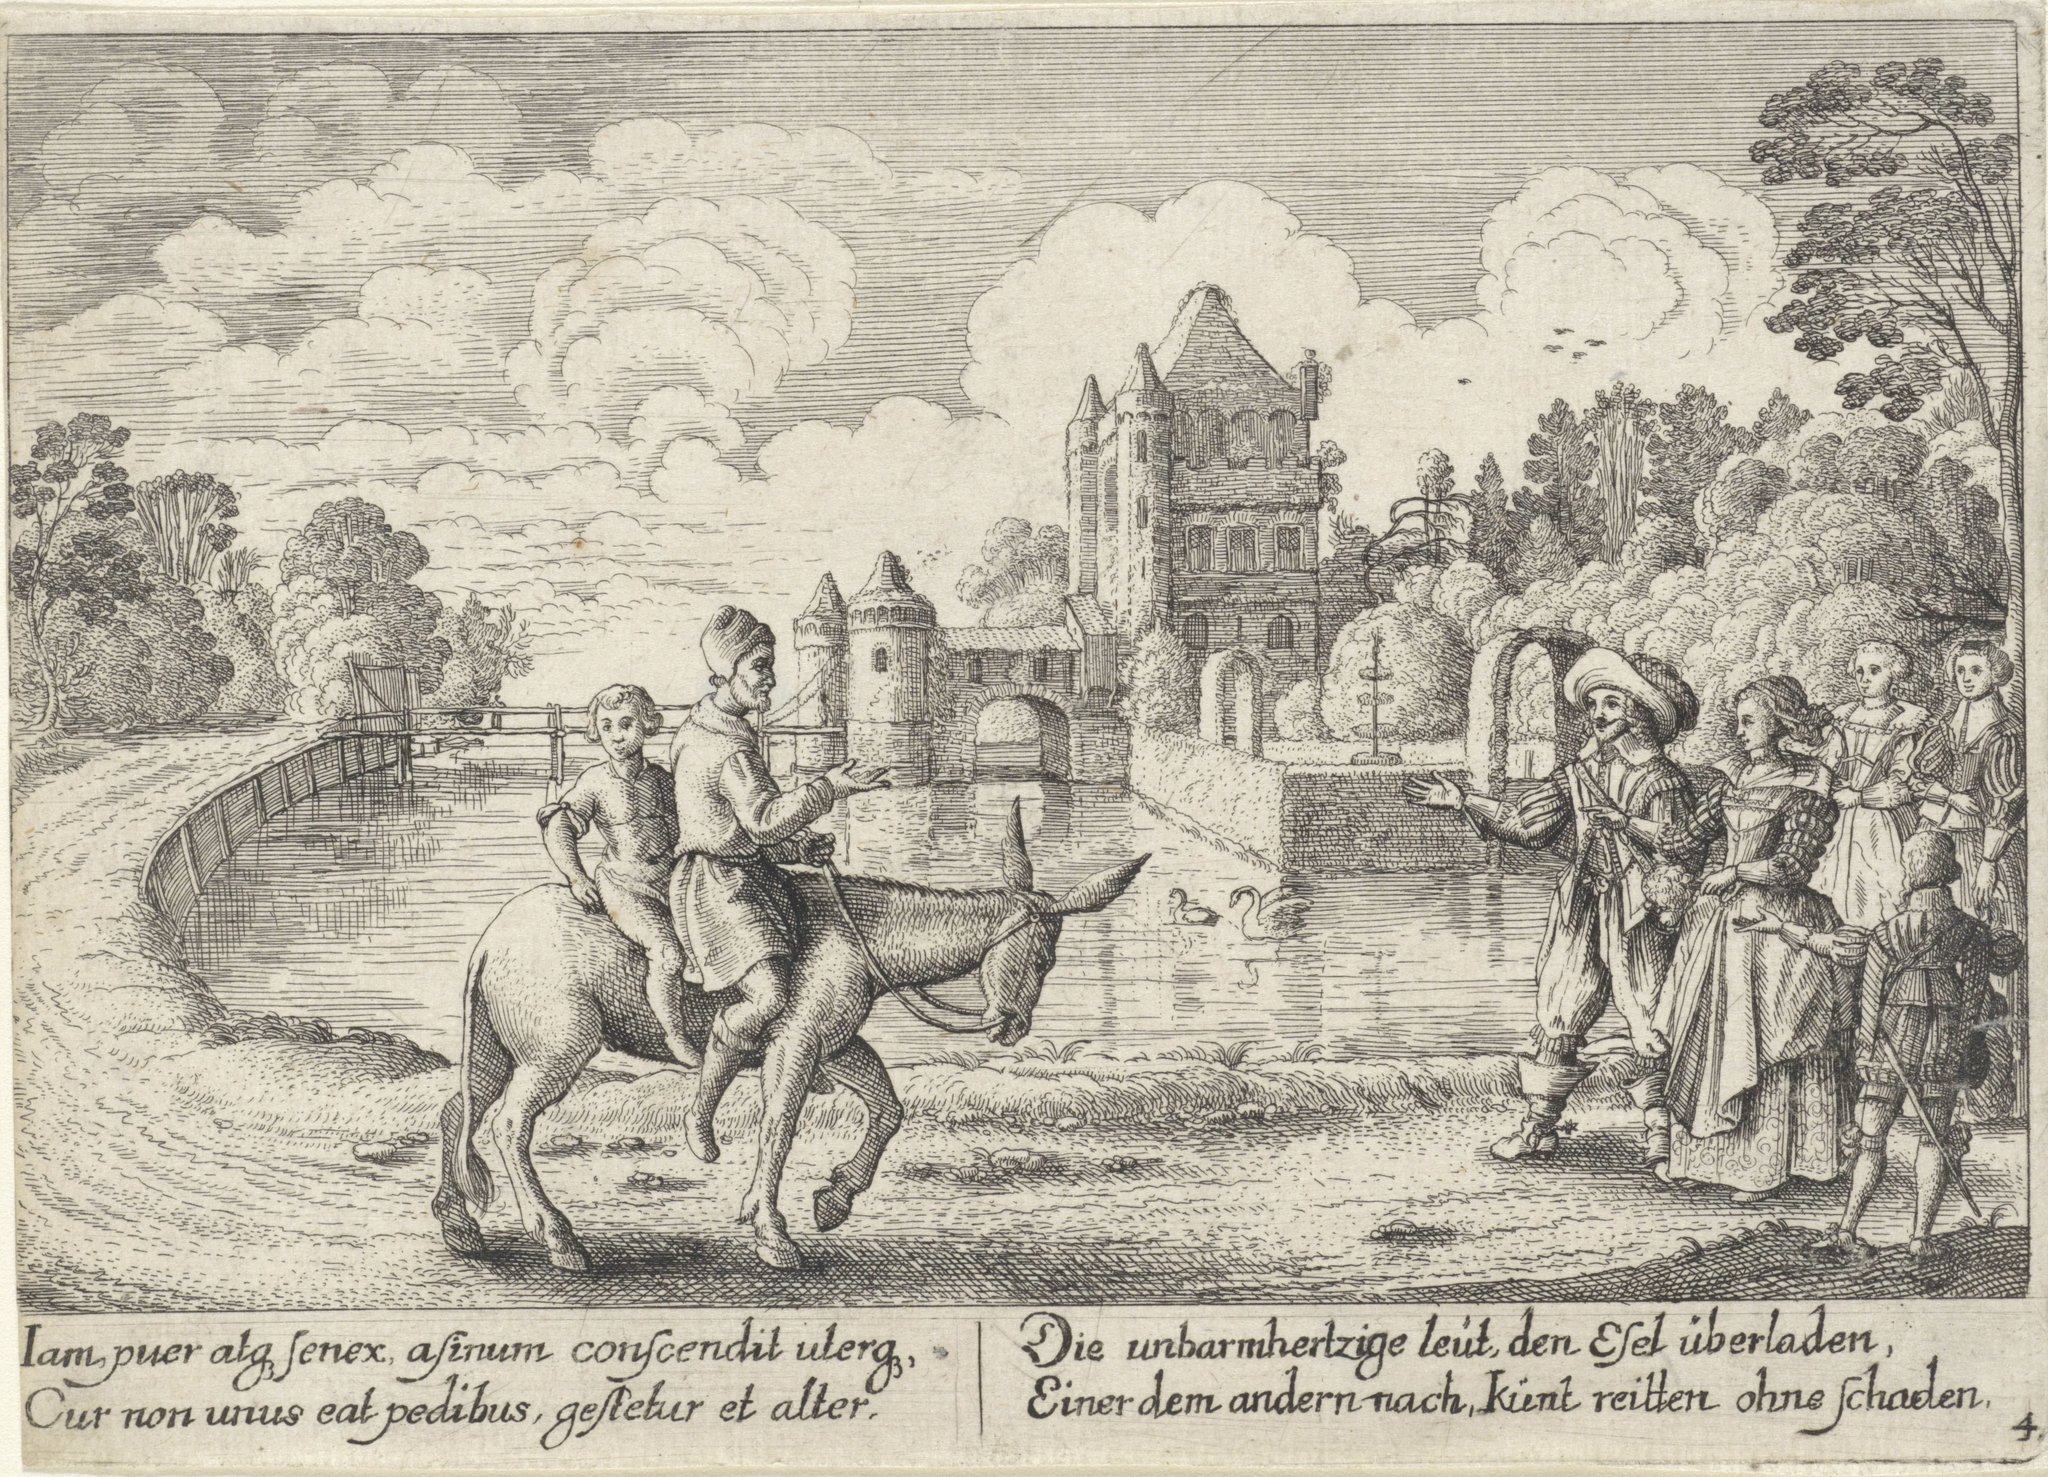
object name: print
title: Fabel van de boer en zijn ezel; Zowel de boer als zijn zoon zitten op de ezel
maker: wenceslaus hollar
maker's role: draughtsman, print maker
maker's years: 1607-1677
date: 1627-1628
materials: paper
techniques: etching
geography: northern netherlands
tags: ass, donkey, fables of aesop : use 85(...)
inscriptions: collector's mark: Lugt 2228